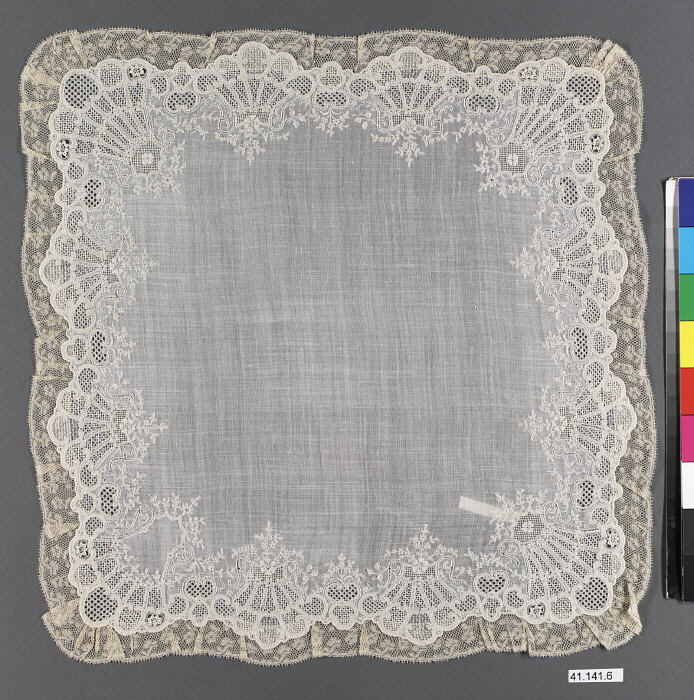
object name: handkerchief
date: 1867-1900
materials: linen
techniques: lace